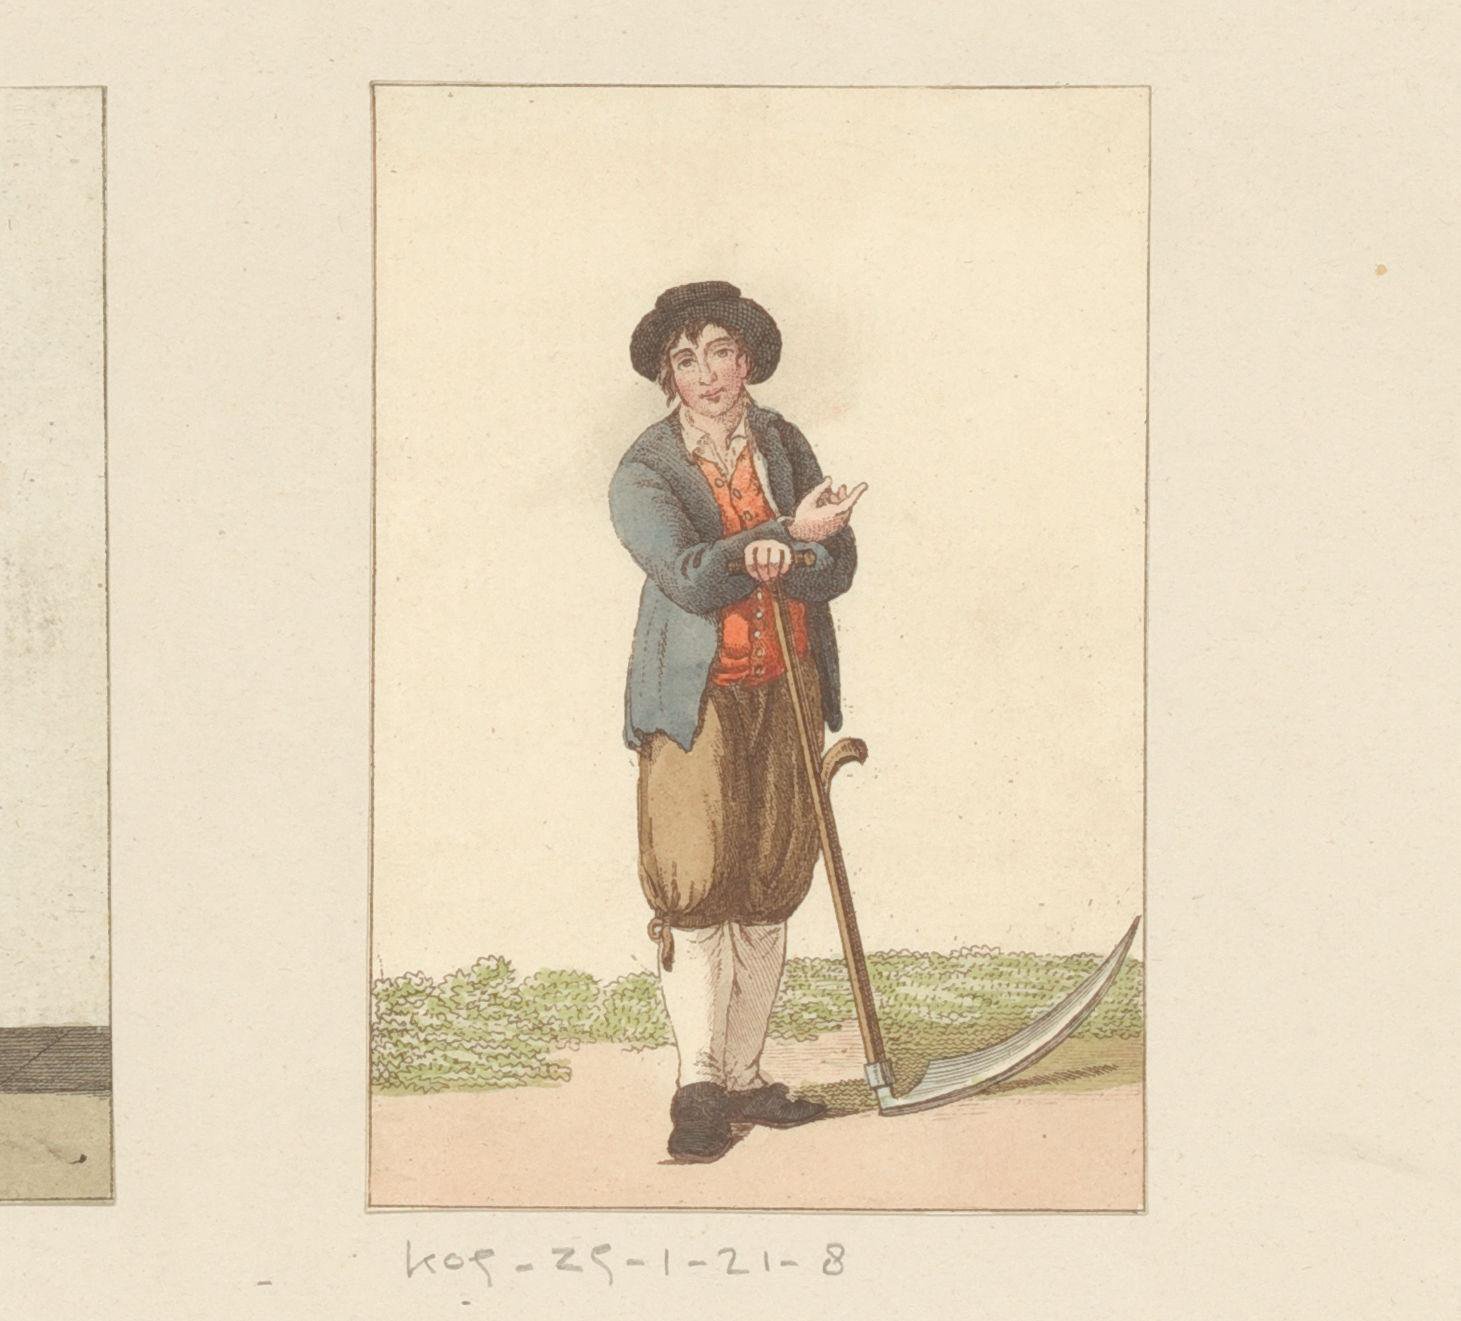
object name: print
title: Staande boer met zeis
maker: Anonymous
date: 1700-1799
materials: paper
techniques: etching, hand coloring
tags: agricultural implements: scythe, standing figure, farmers, clothes, costume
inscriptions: collector's mark: Lugt 1641, stamp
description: Onderwerpsrubrieken binnen de Atlas Zeden en Gewoonten: Zeden en Gewoonten in Engeren Zin, De Kleeding, Kleederdrachten (tijdvakken), De 18de eeuw (de pruikentijd). Mannen en vrouwen.